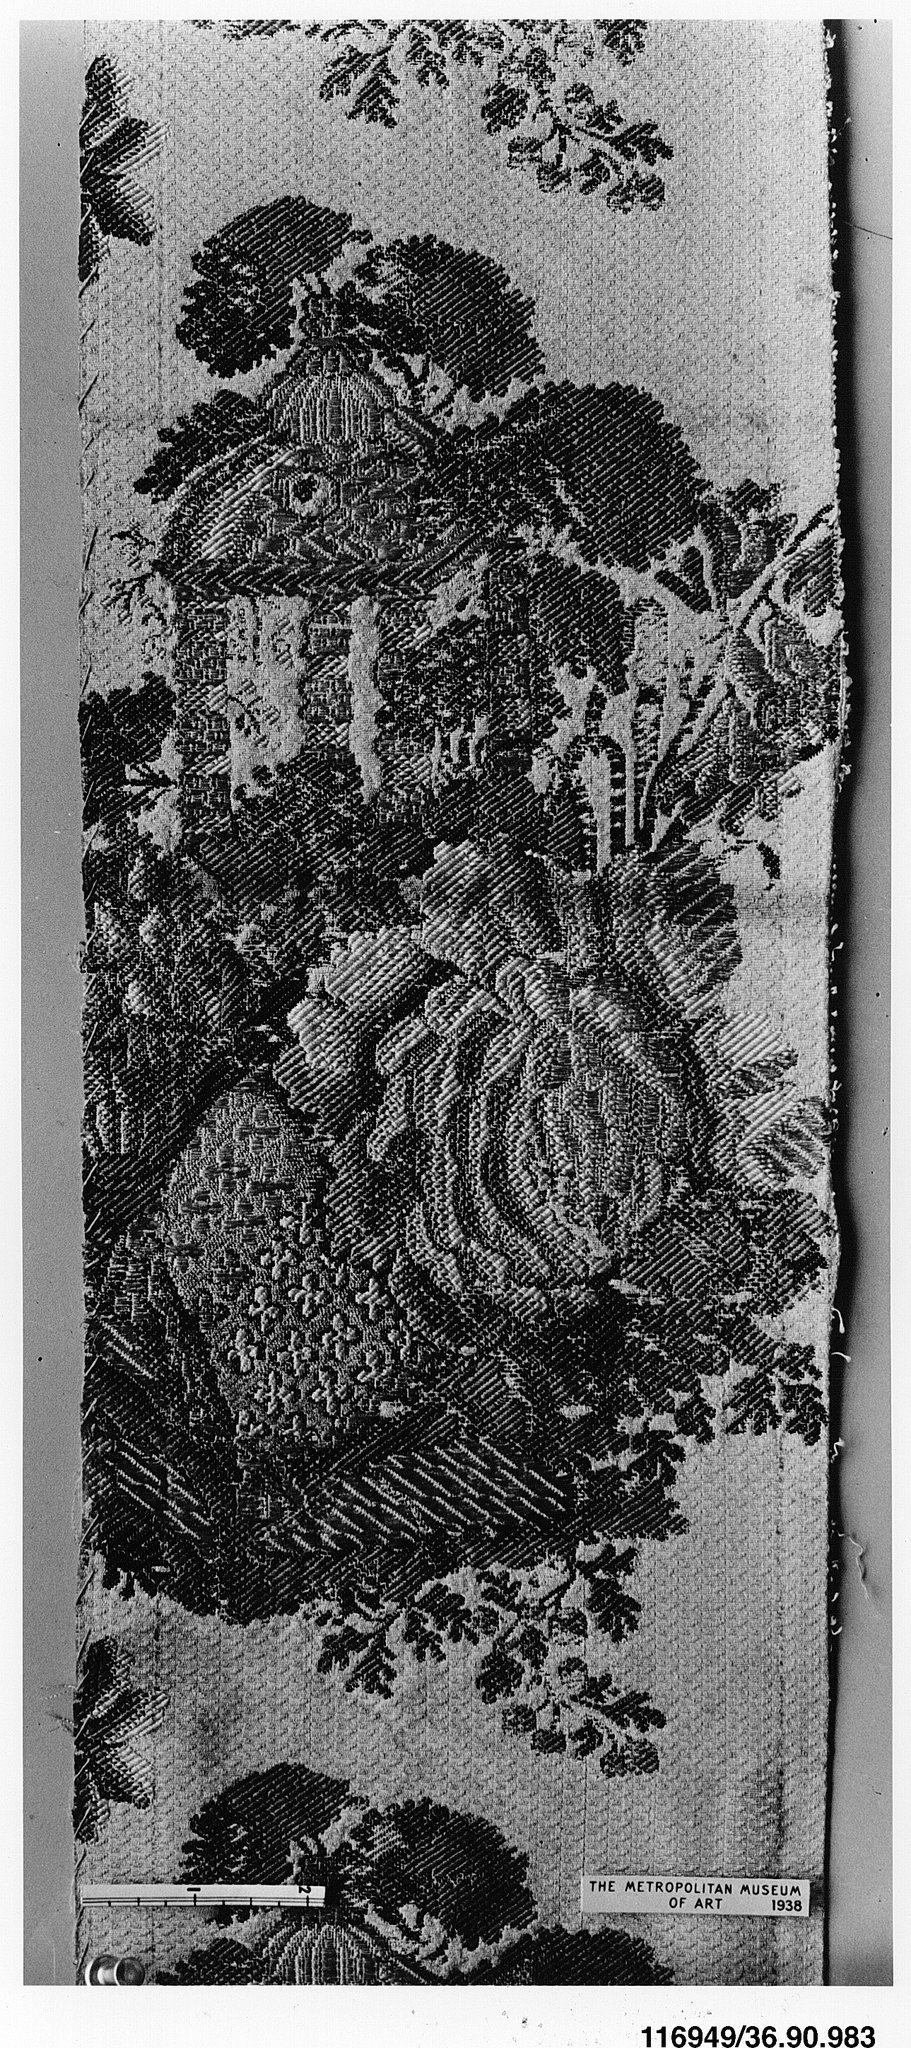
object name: piece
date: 1735-1740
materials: metal thread, silk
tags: flowers